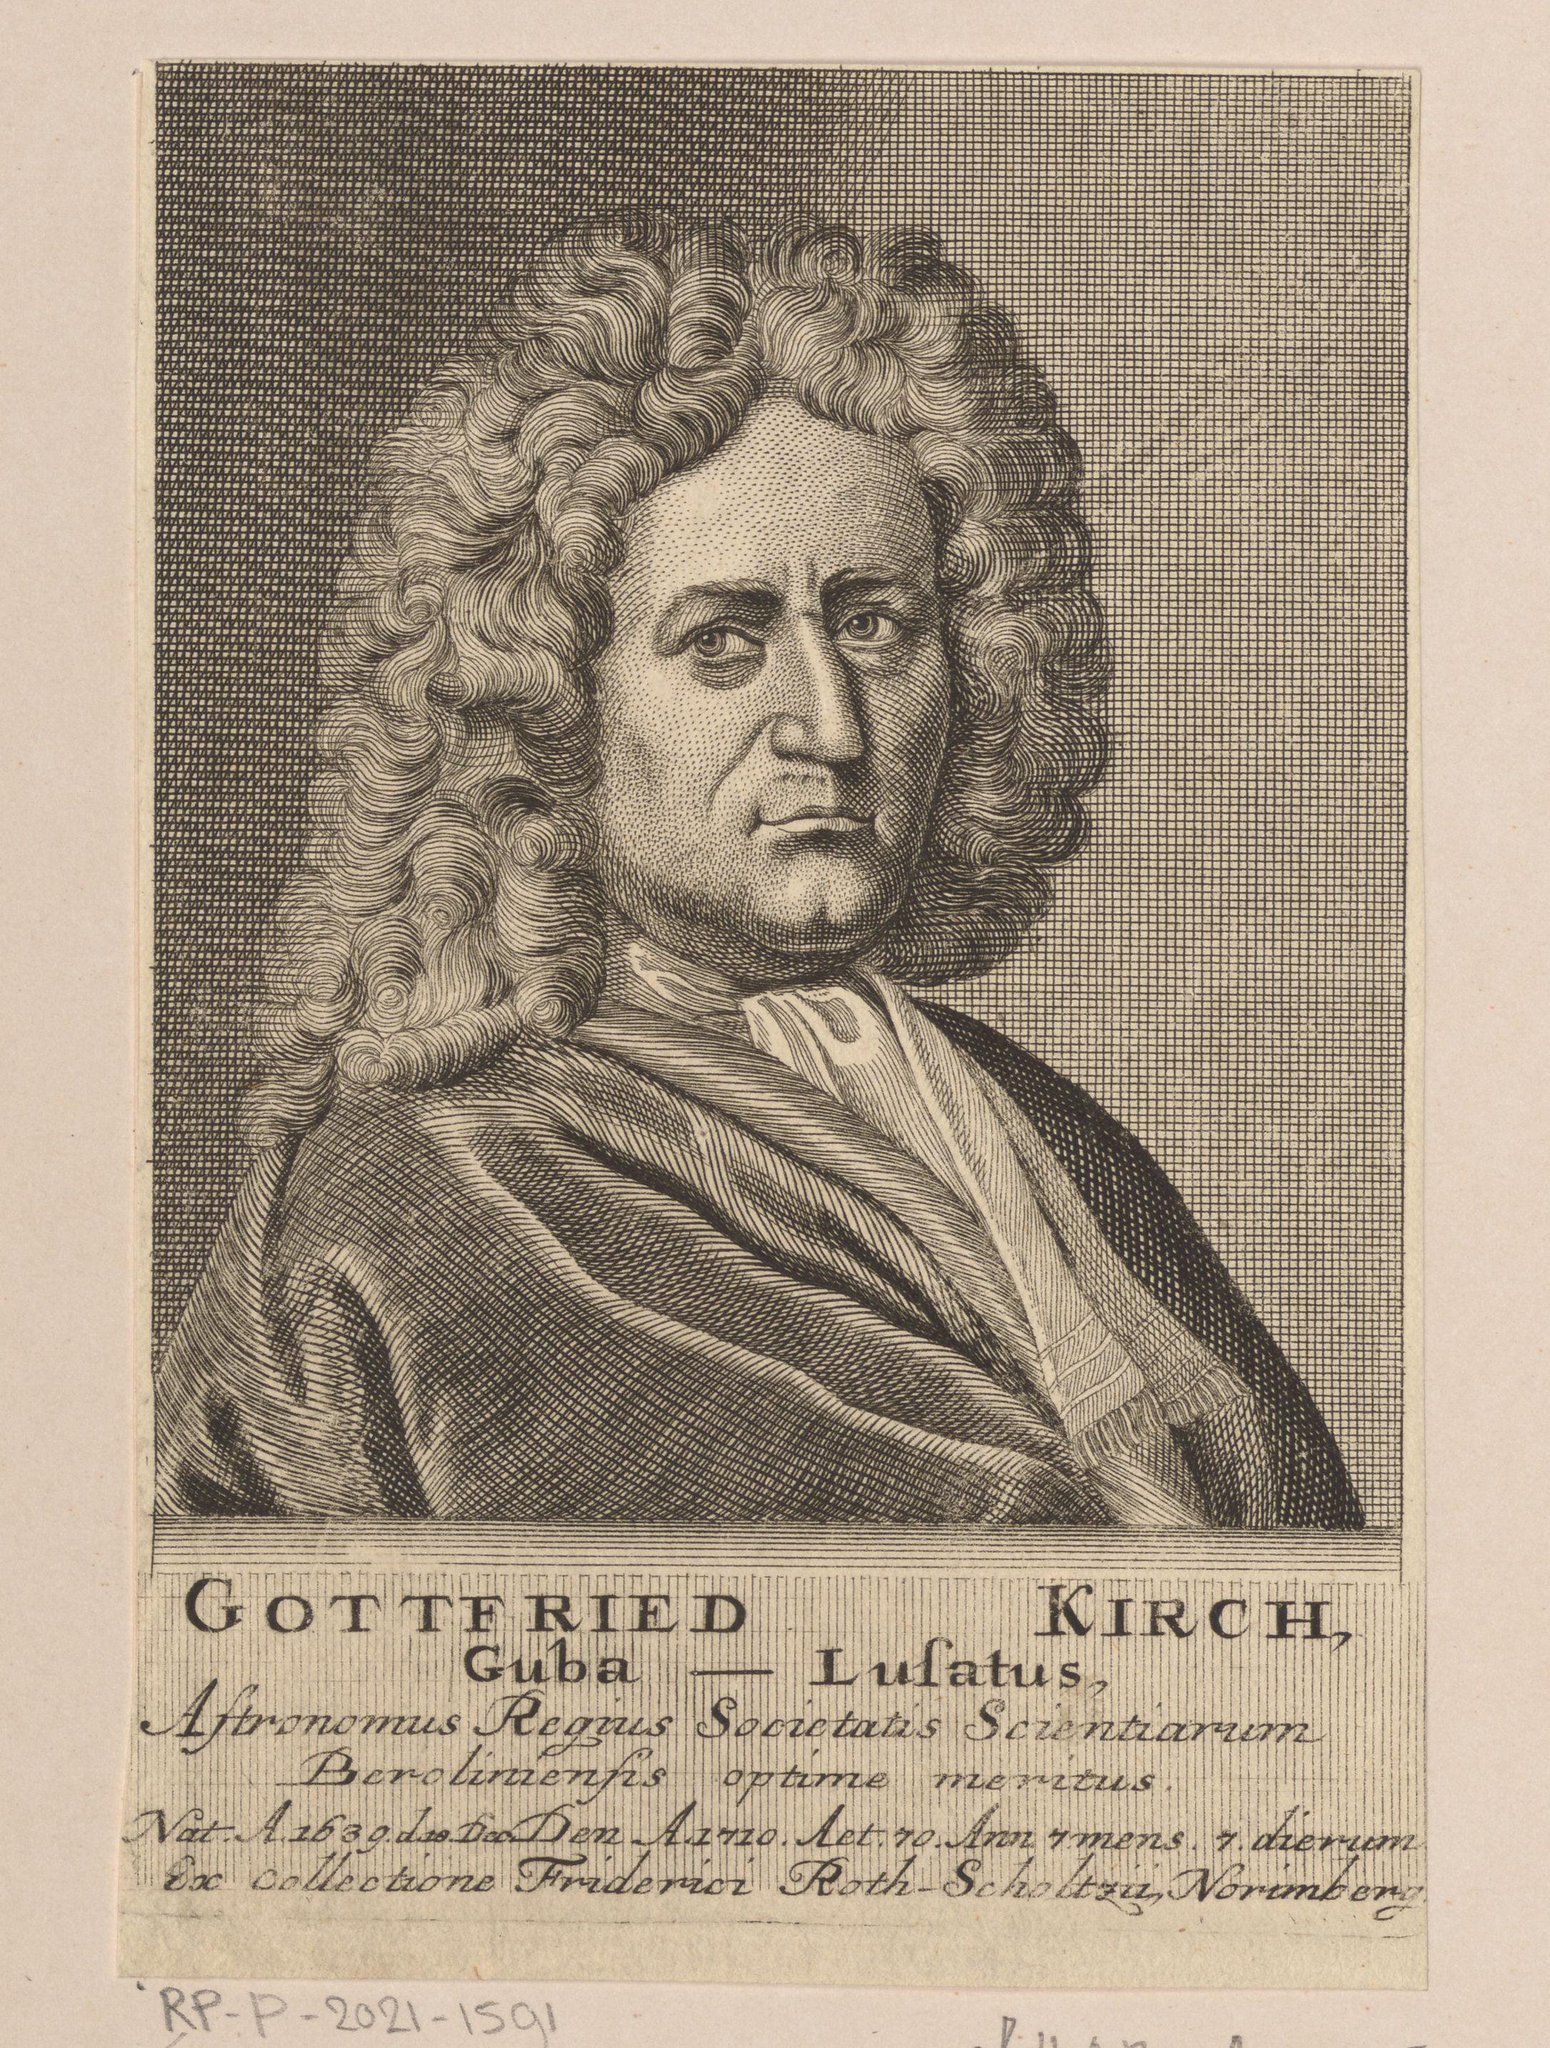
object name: print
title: Portret van Gottfried Kirch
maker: Anonymous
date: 1710-1799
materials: paper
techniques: engraving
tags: berlin, historical persons